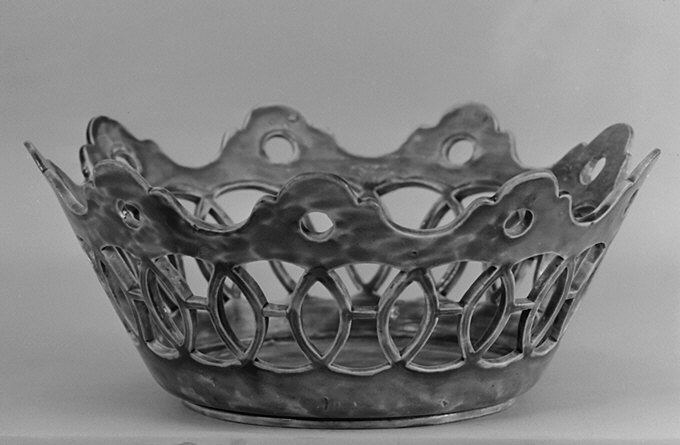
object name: basket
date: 1760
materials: stoneware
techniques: salt glaze